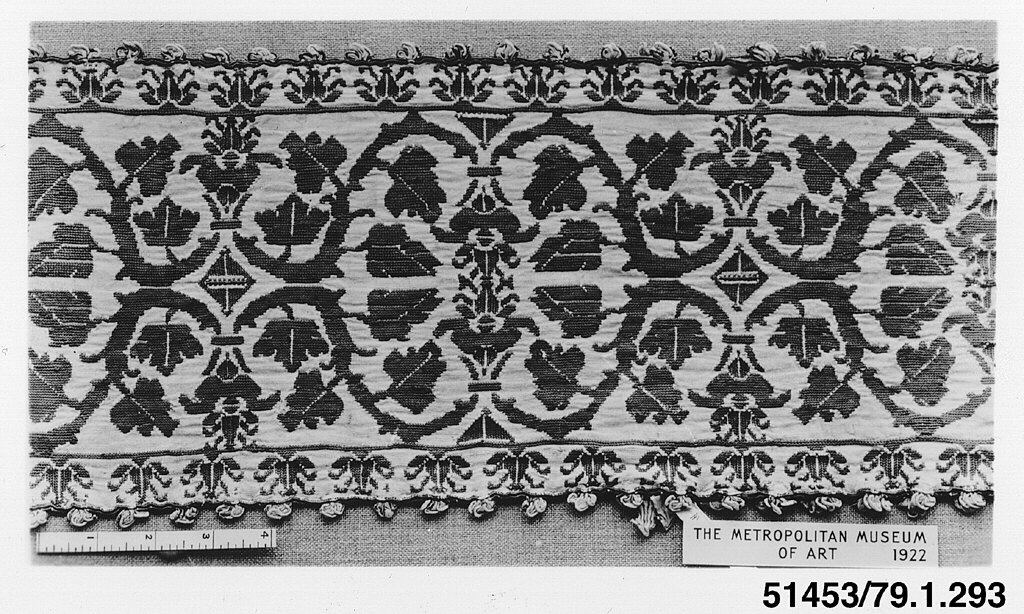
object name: border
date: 1601-1700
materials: linen, silk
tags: leaves